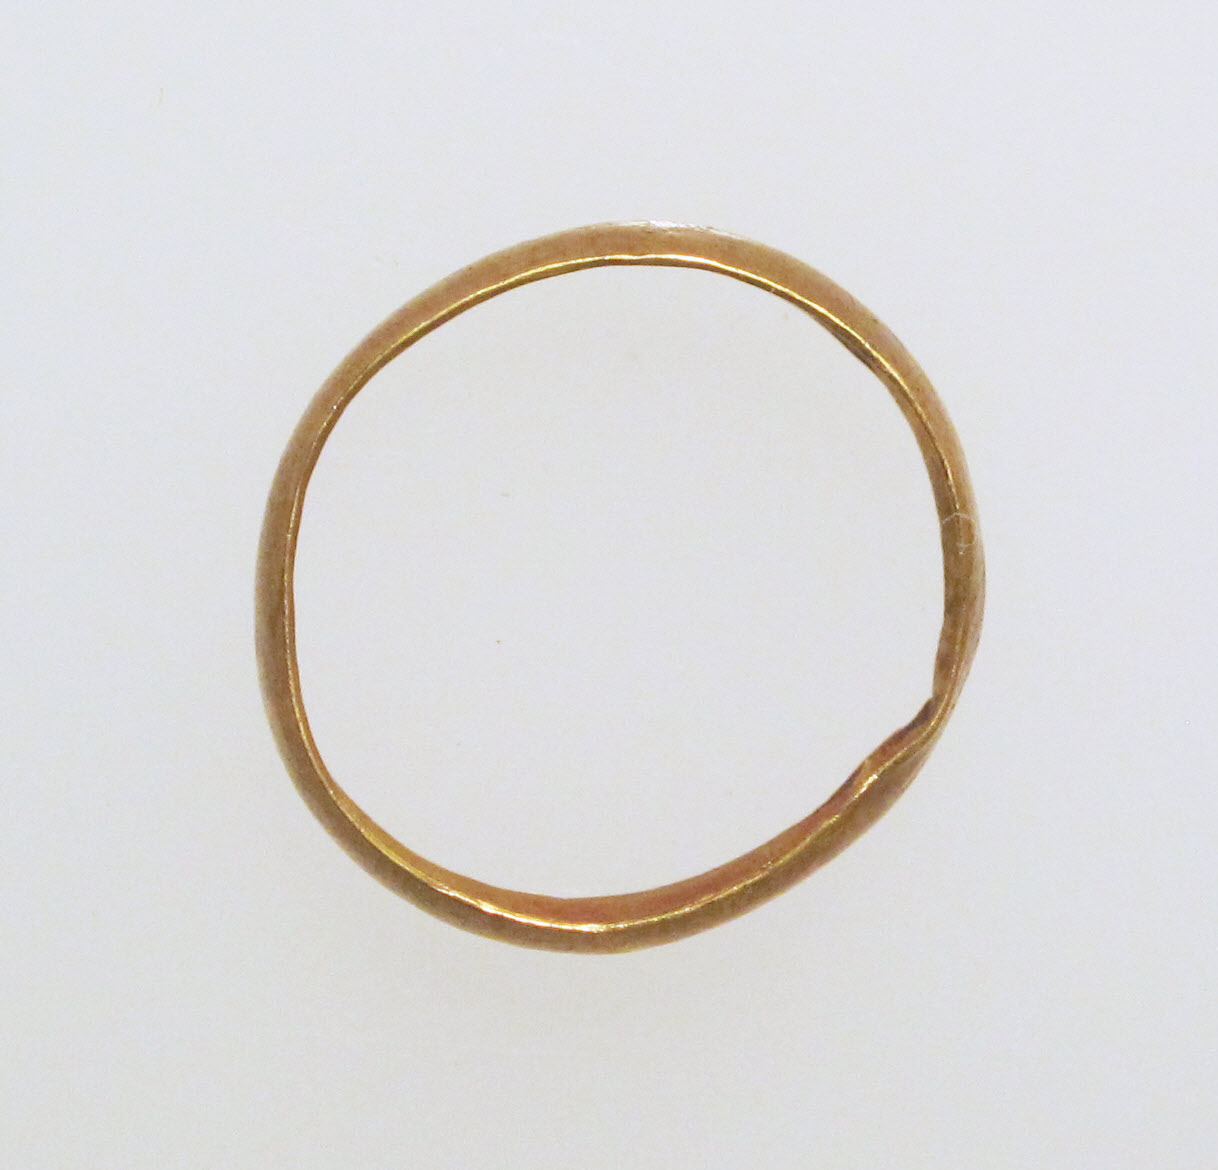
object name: ring with hollow hoop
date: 7000 BCE-330 CE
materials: gold